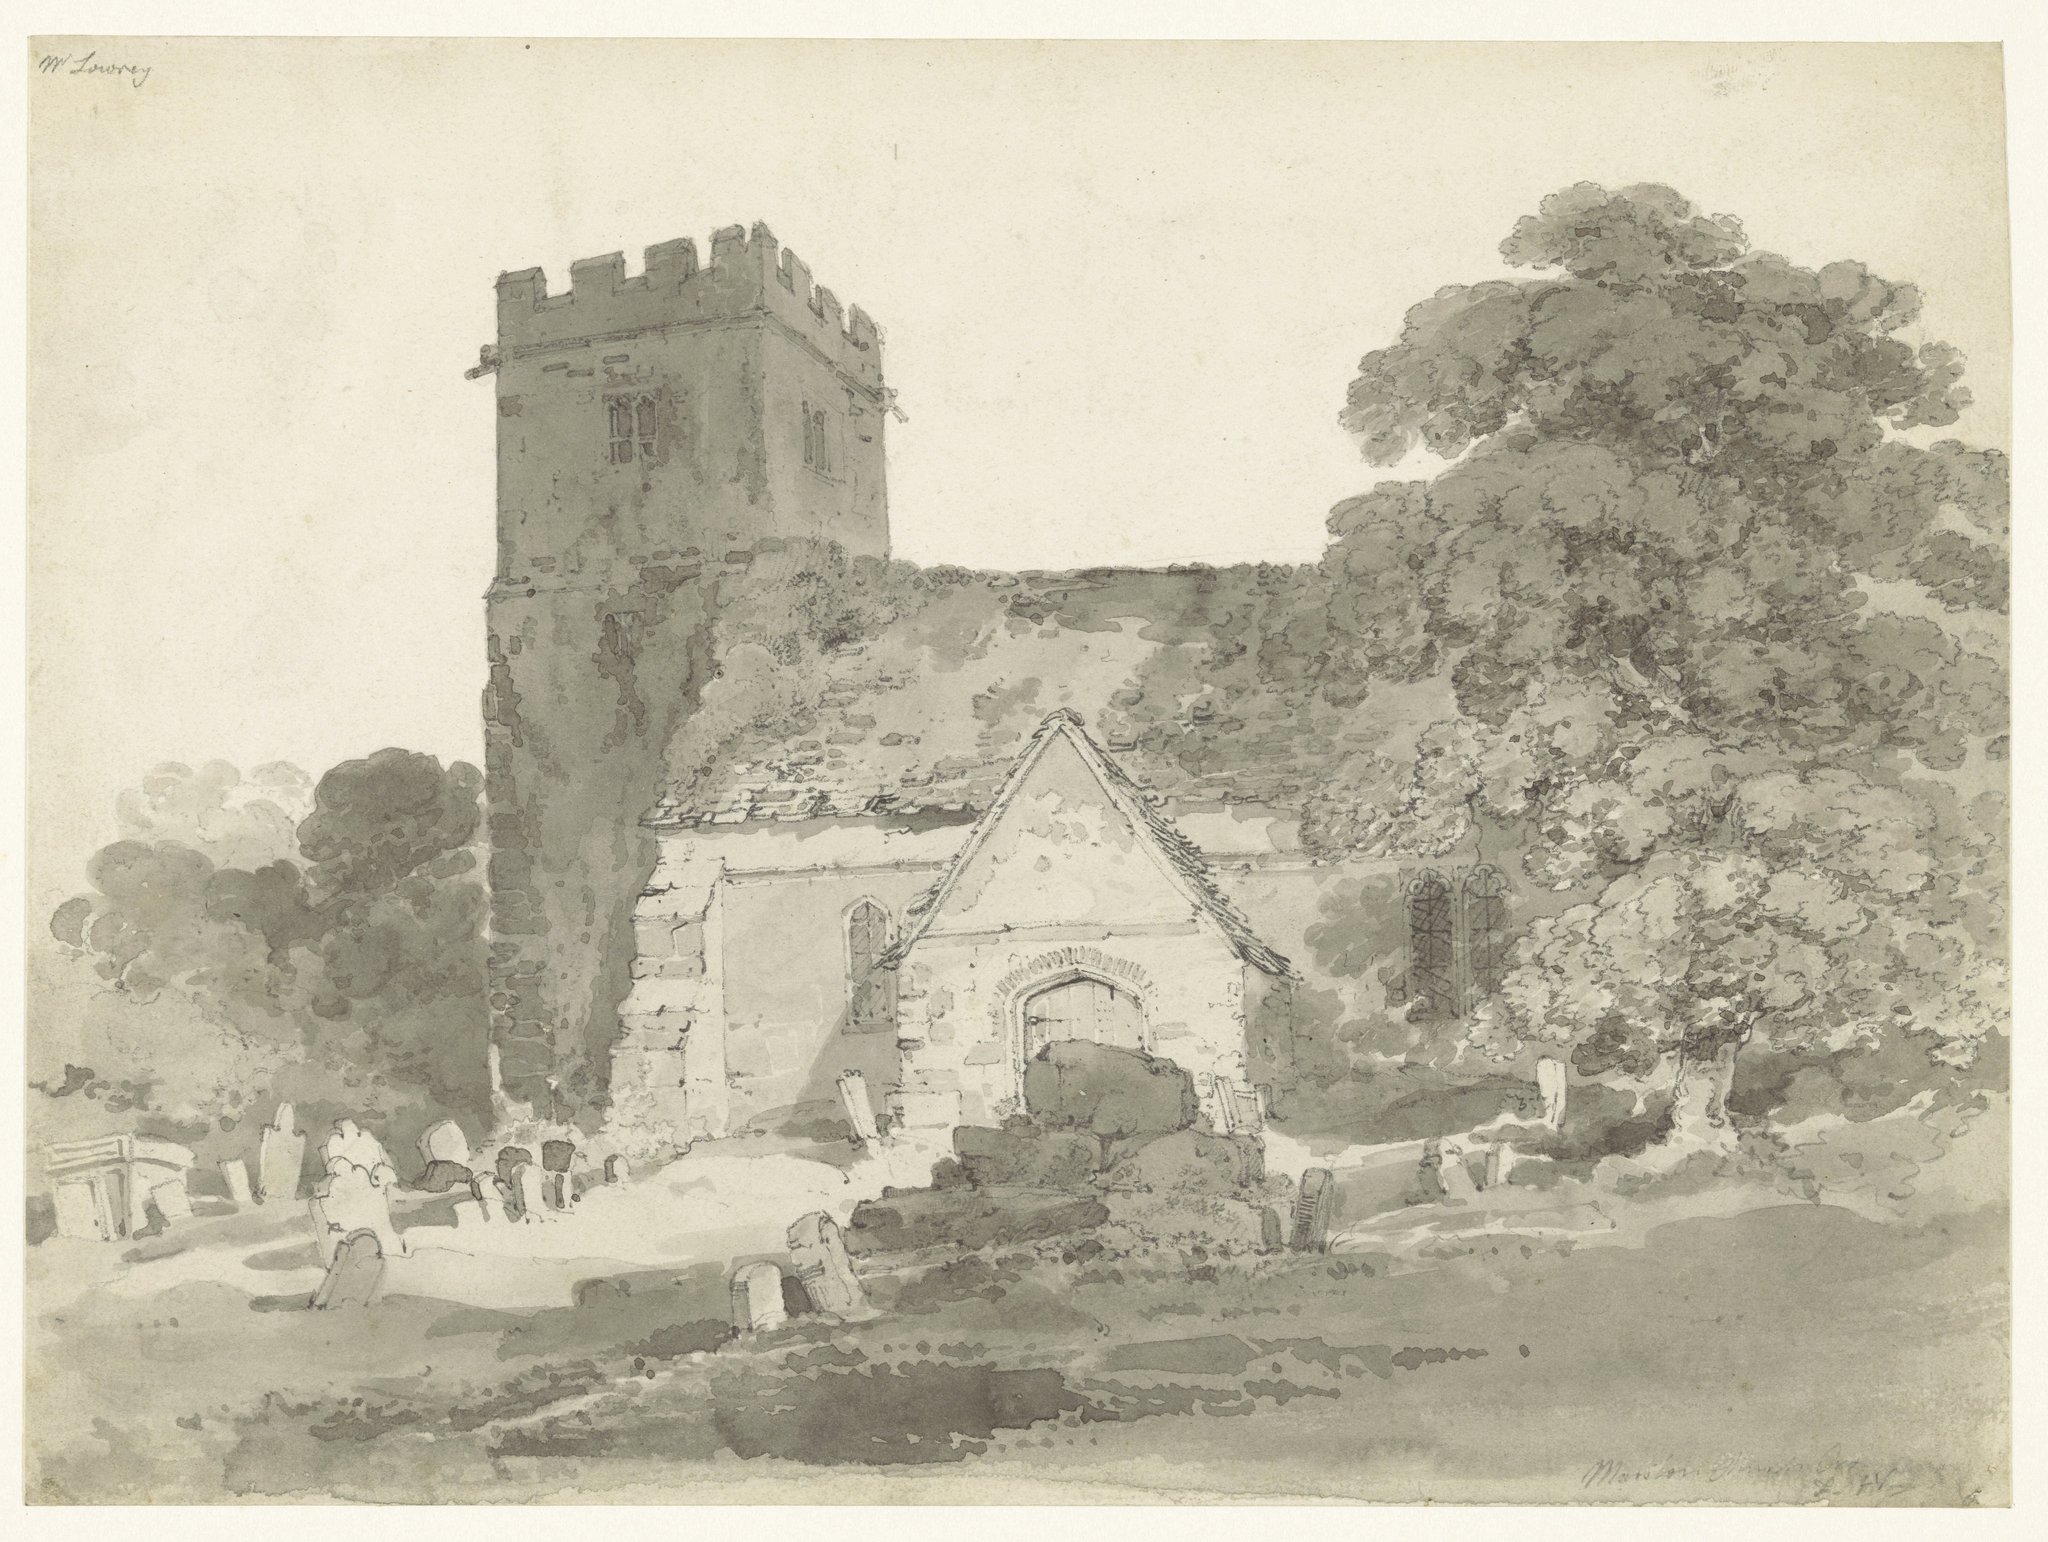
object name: drawing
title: Marston Church te Oxon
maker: hugh oneill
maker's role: draughtsman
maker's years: 1784-1824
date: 1794-1824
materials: paper, pencil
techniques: brush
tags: church (exterior)